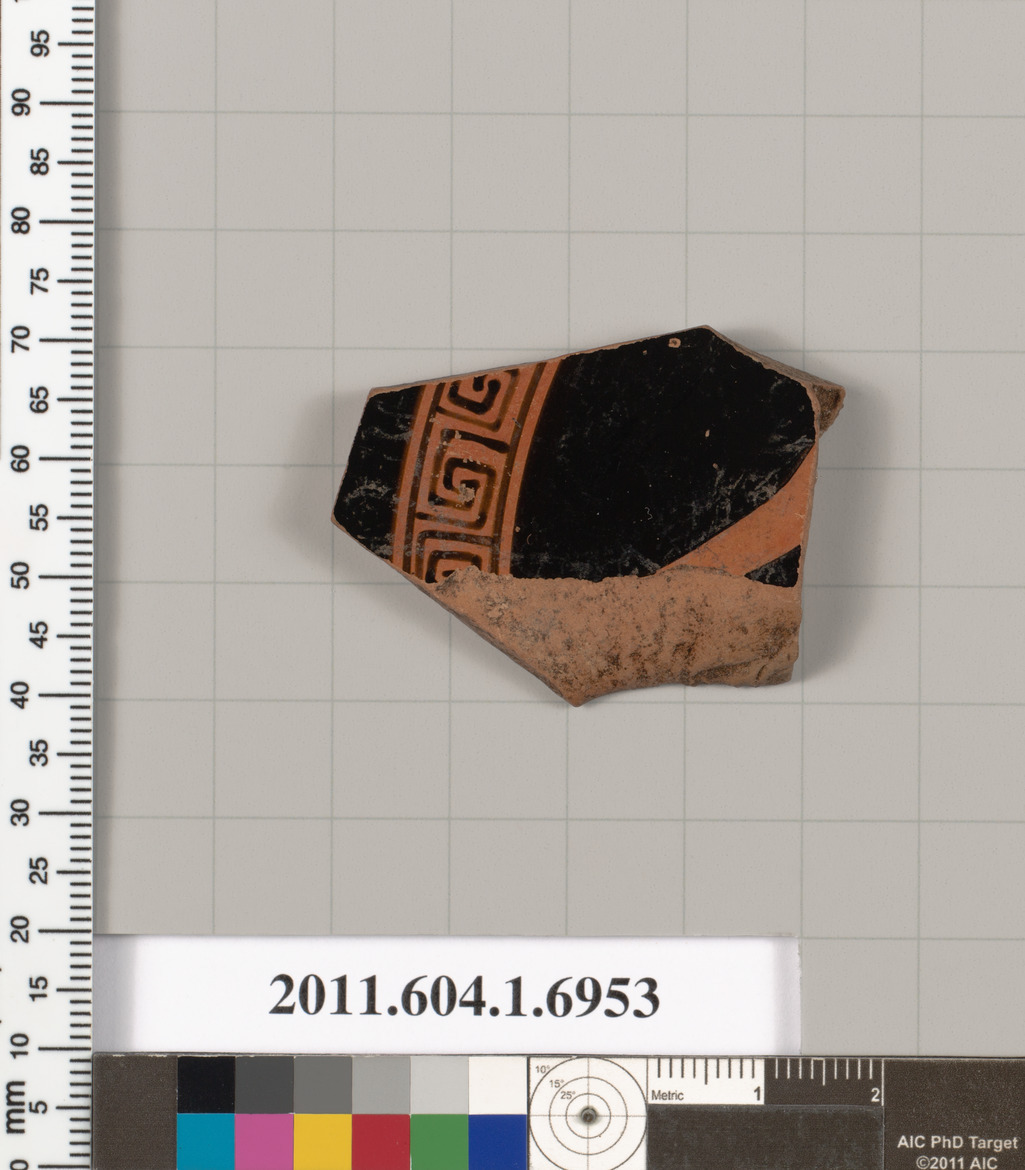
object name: kylix fragment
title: Terracotta fragment of a kylix (drinking cup)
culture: greek, attic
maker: painter of the paris gigantomachy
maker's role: artist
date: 480-470 BCE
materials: terracotta